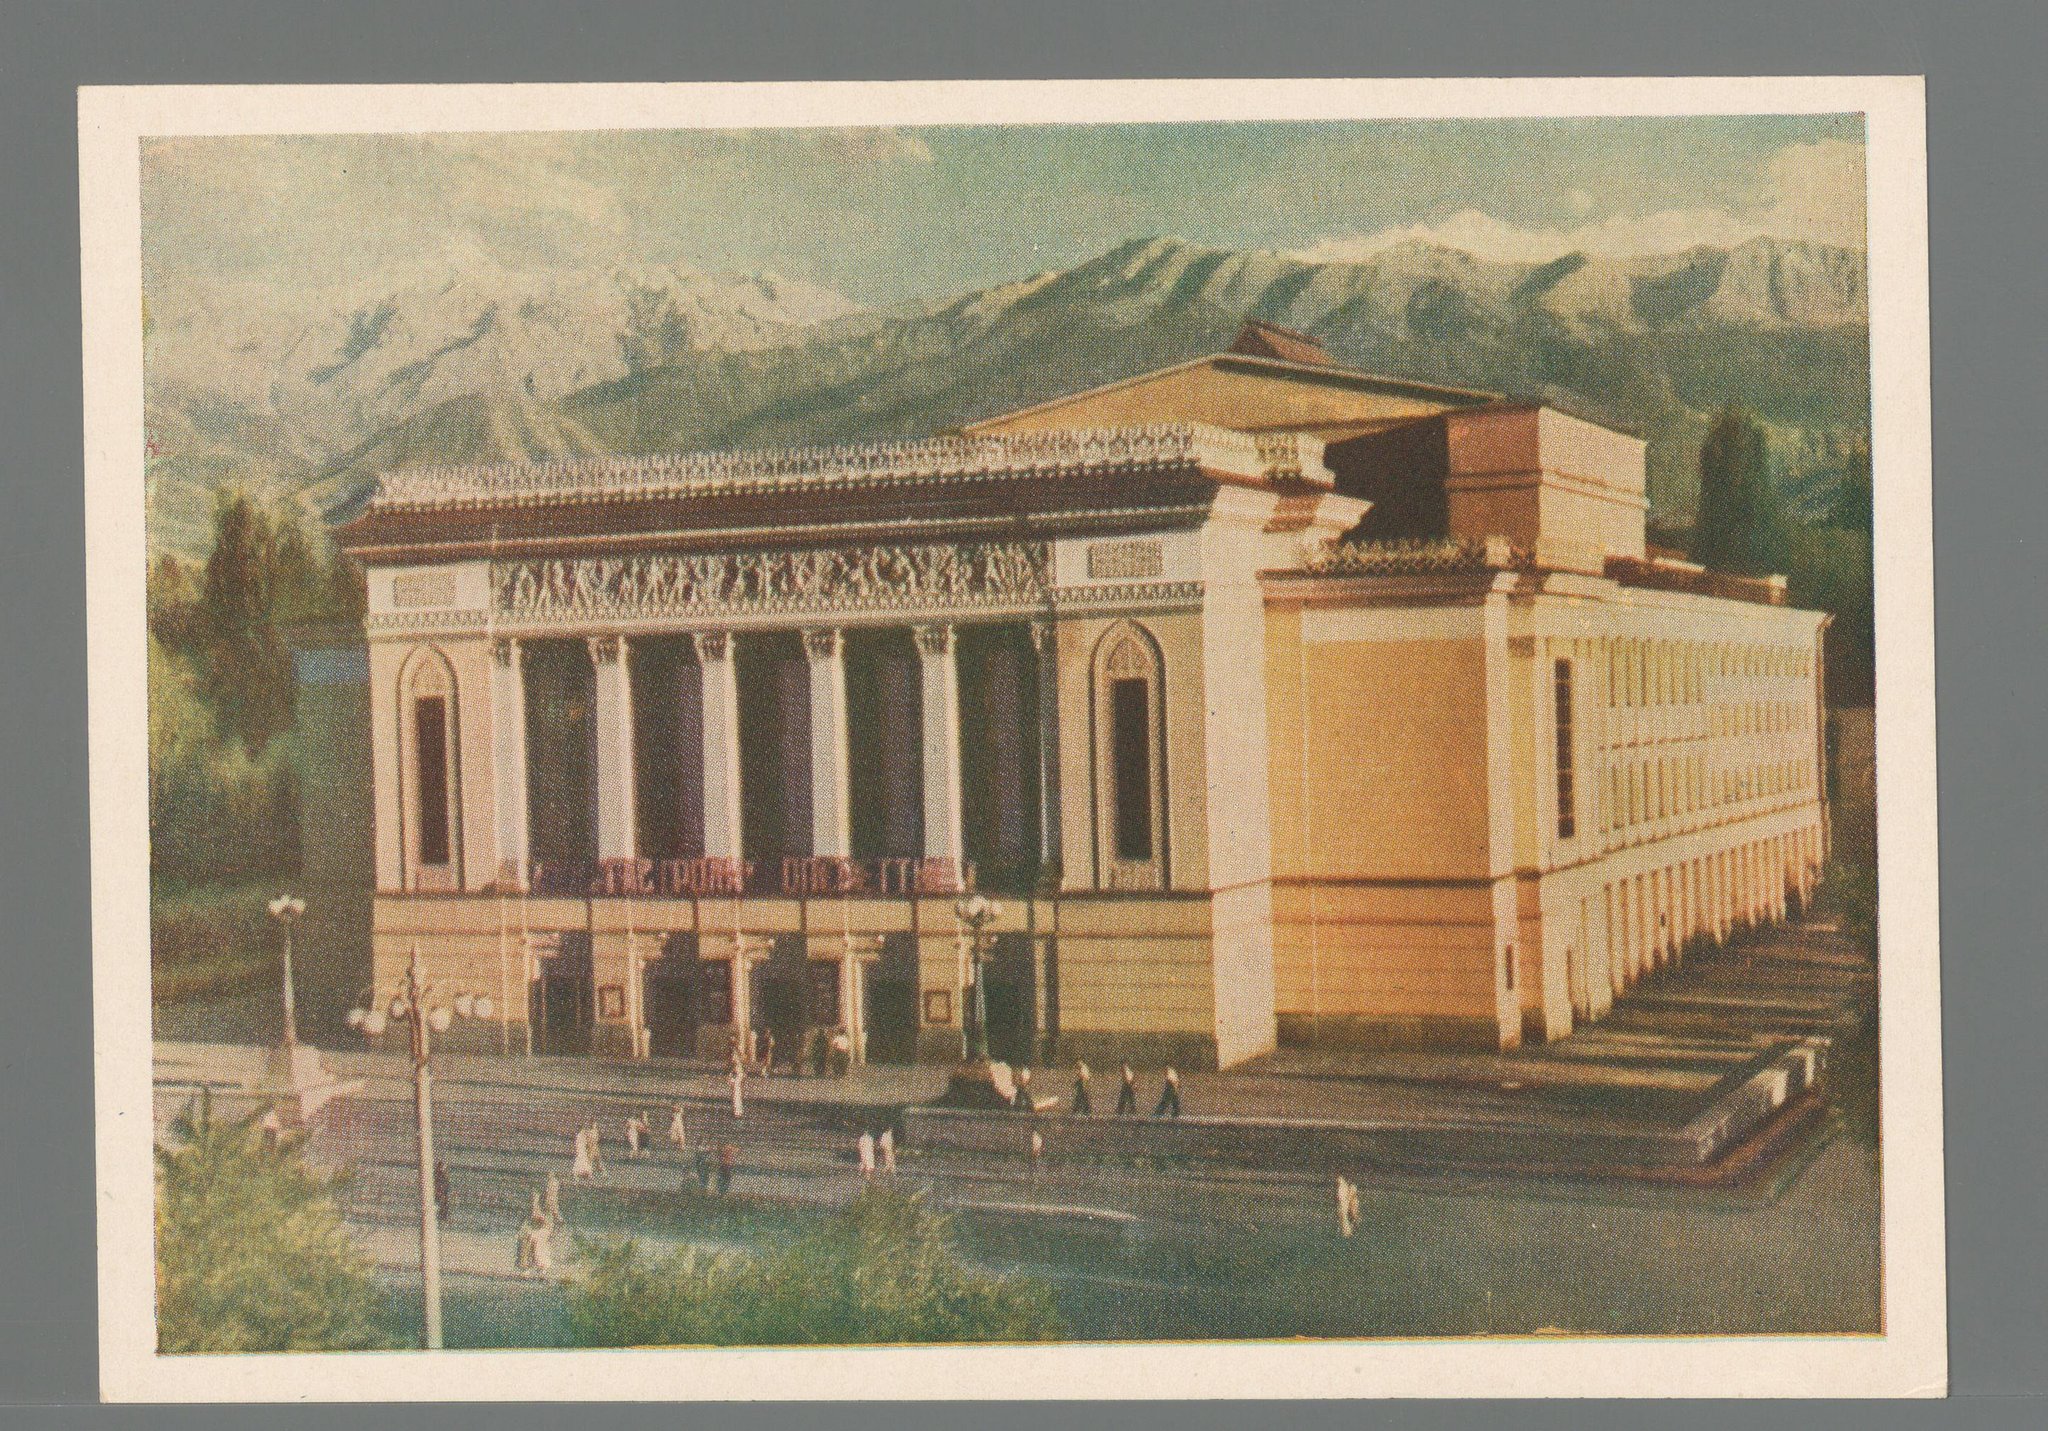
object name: ansichtkaart, prentbriefkaart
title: Kazakh S.S.R. Alma-Ata. Abai Opera Theatre / R.S.S. de Kazakhie. Alma-Ata. Opéra Abaï / Kasachische SSR. Alma-Ata. Gebäude des Abai-Operntheaters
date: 1956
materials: cardboard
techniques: color autotype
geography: moscow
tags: theatre (building), mountains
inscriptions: date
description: De titel op object staat ook in het Russisch.